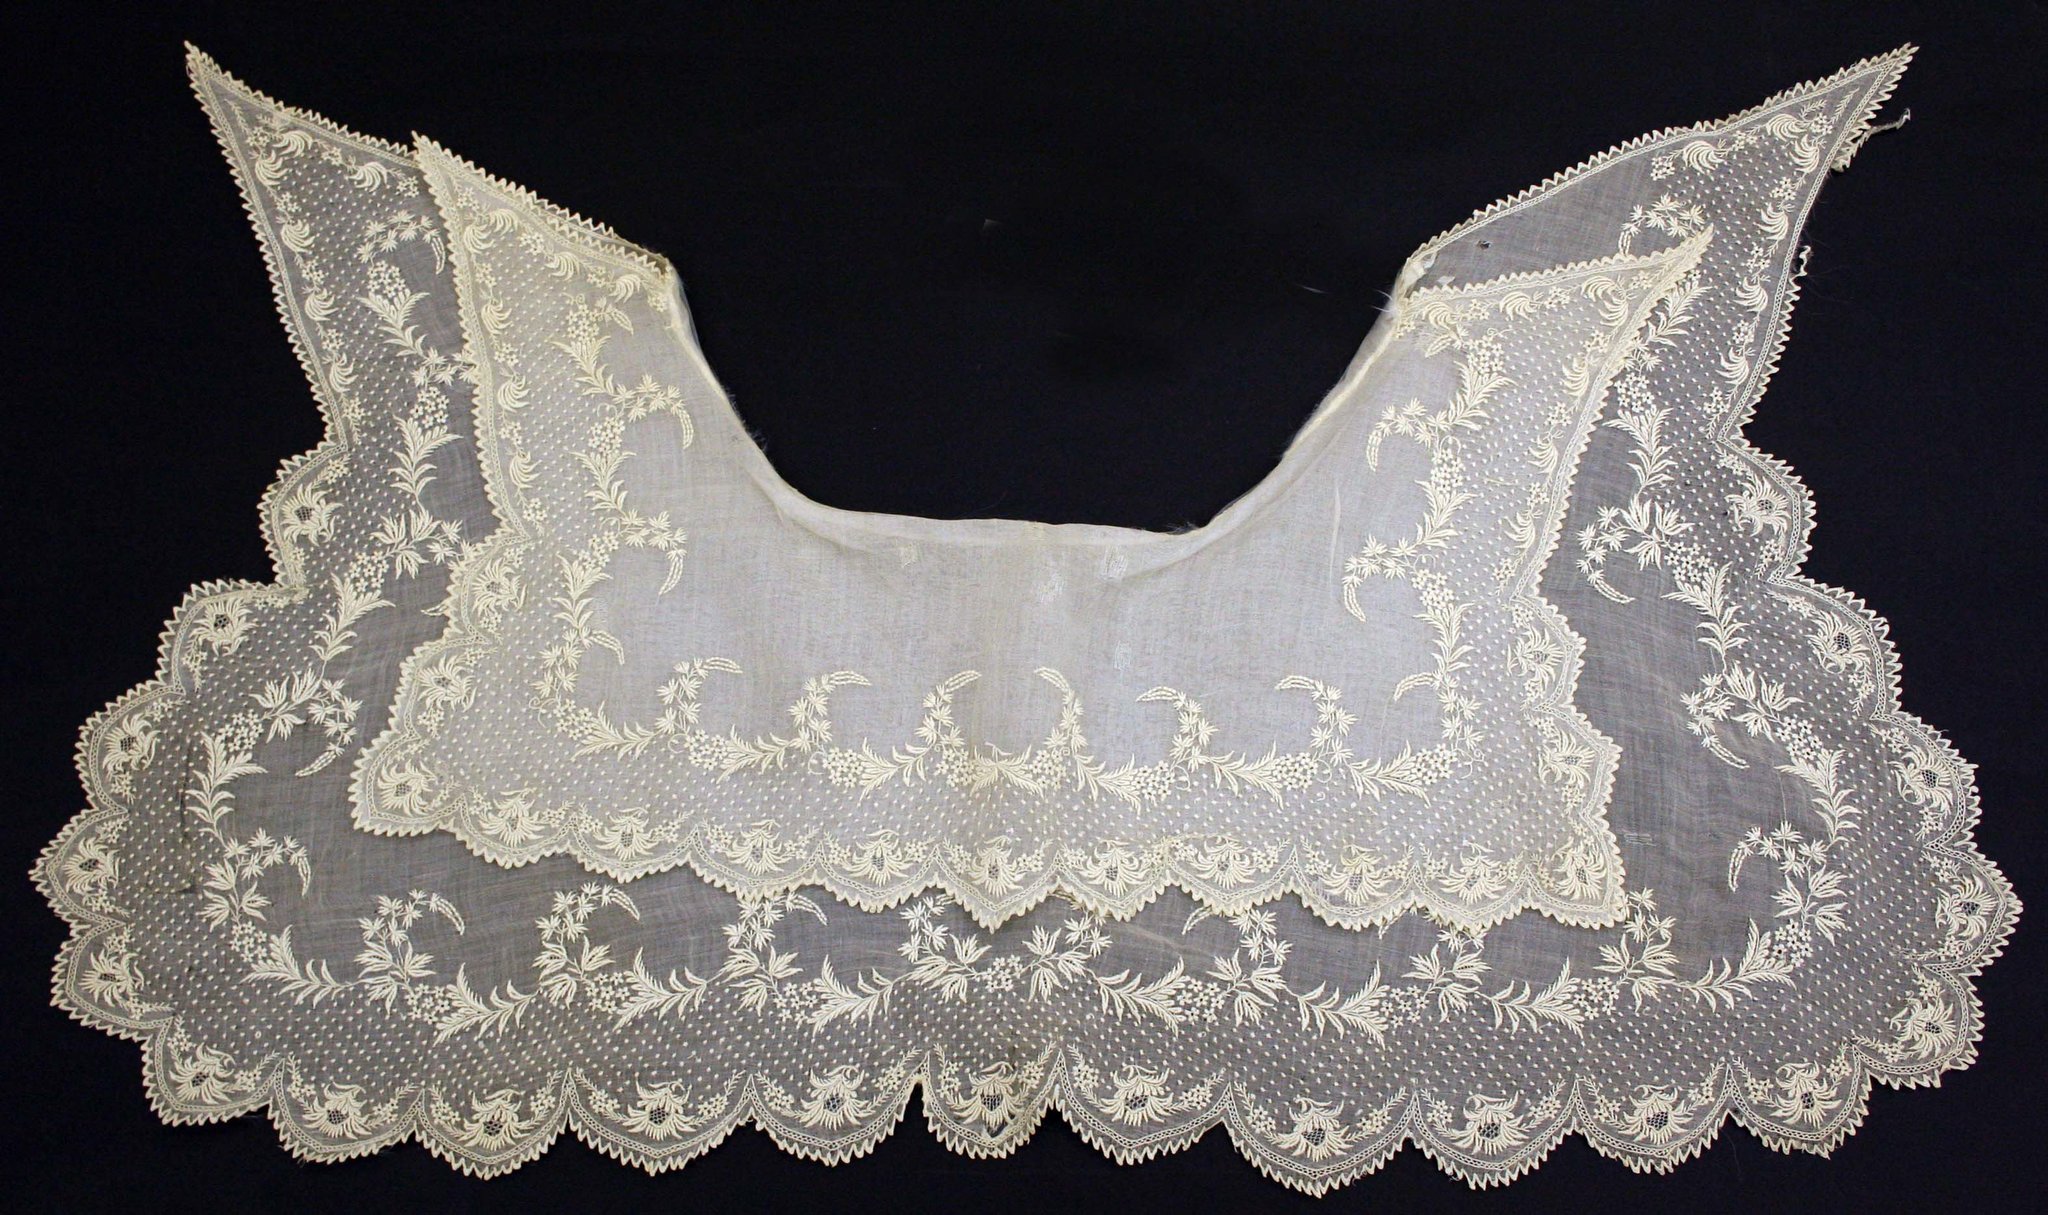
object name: collar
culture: american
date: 1830-1839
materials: cotton